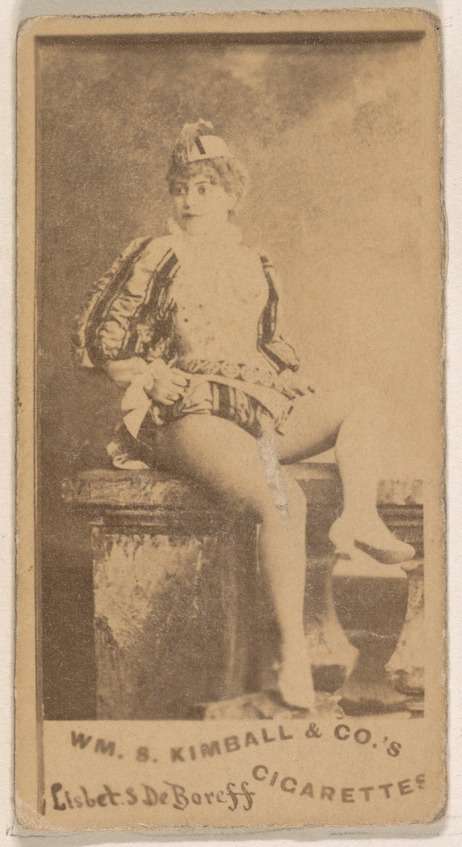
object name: photograph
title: Lisbets DeBoreff, from the Actresses series (N203) issued by Wm. S. Kimball & Co.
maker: william s. kimball & company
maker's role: publisher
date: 1889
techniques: color lithograph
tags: portraits,women,actresses